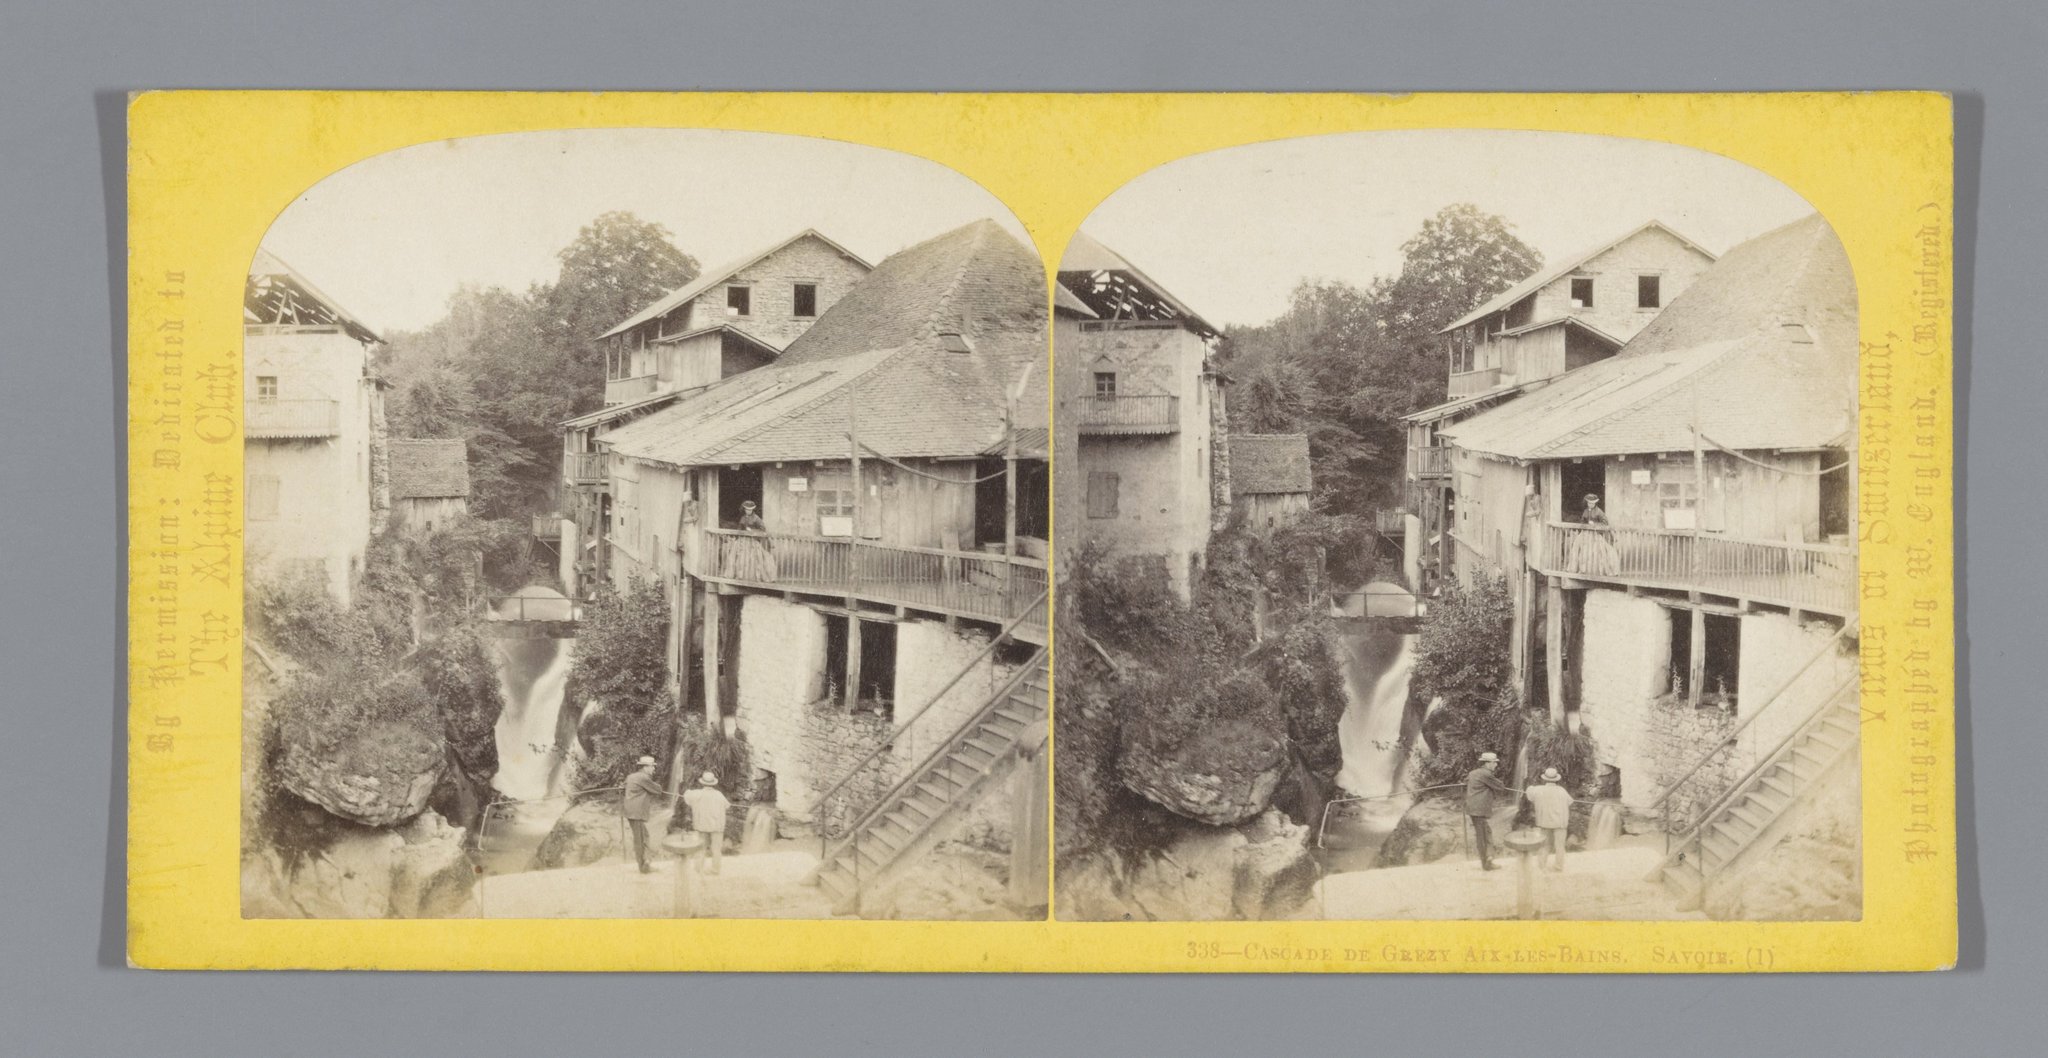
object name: stereograph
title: Gezicht op een waterval te Aix-les-Bains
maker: william england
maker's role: fotograaf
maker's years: 1816-1896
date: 1850-1880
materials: cardboard, photographic support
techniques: albumen print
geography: aix-les-bains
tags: waterfall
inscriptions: inscription: ‘Views of Switzerland, photographed by W. England. (Registered) Under the Special Patronage of the Alpine Club.’, number: ‘338.’